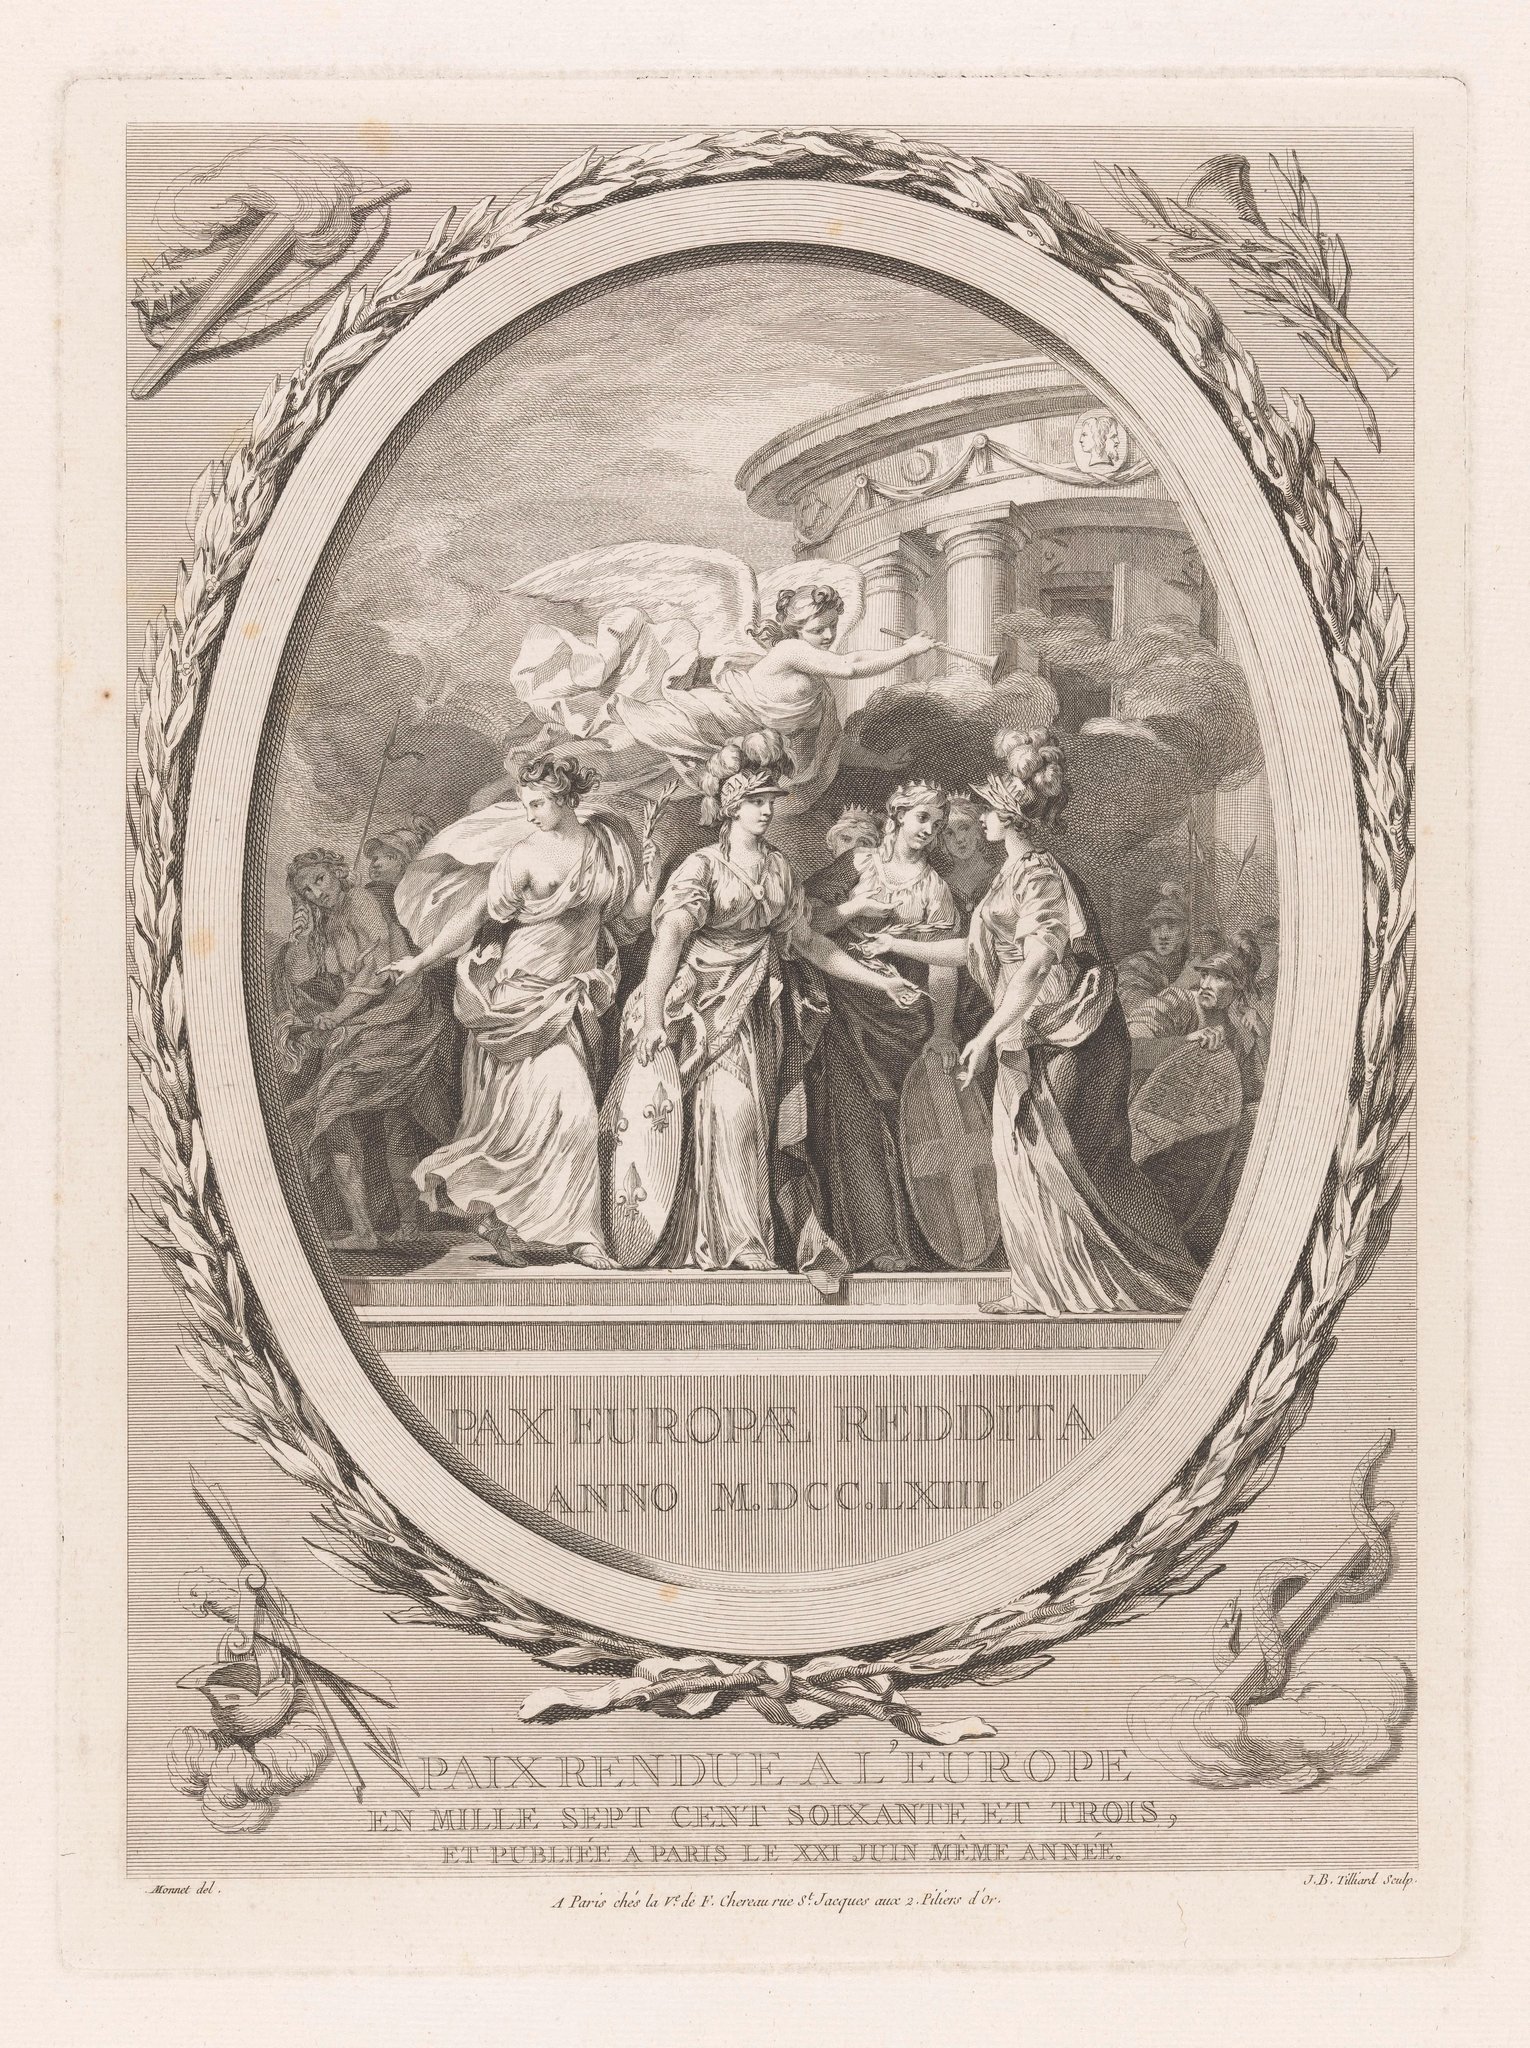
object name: print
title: Paix rendue à l'Europe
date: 1763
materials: paper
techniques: engraving, etching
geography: france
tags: symbols, allegories of peace, 'pax'; 'pace' (ripa)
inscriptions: date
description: Verscheidene allegorische figuren, met links de Vrede, overhandigen elkaar olijftakken bovenaan een trap voor een tempel. Boven hen vliegt een engel en om hen heen staan soldaten. Achter de Vrede, schuilt de Oorlog.